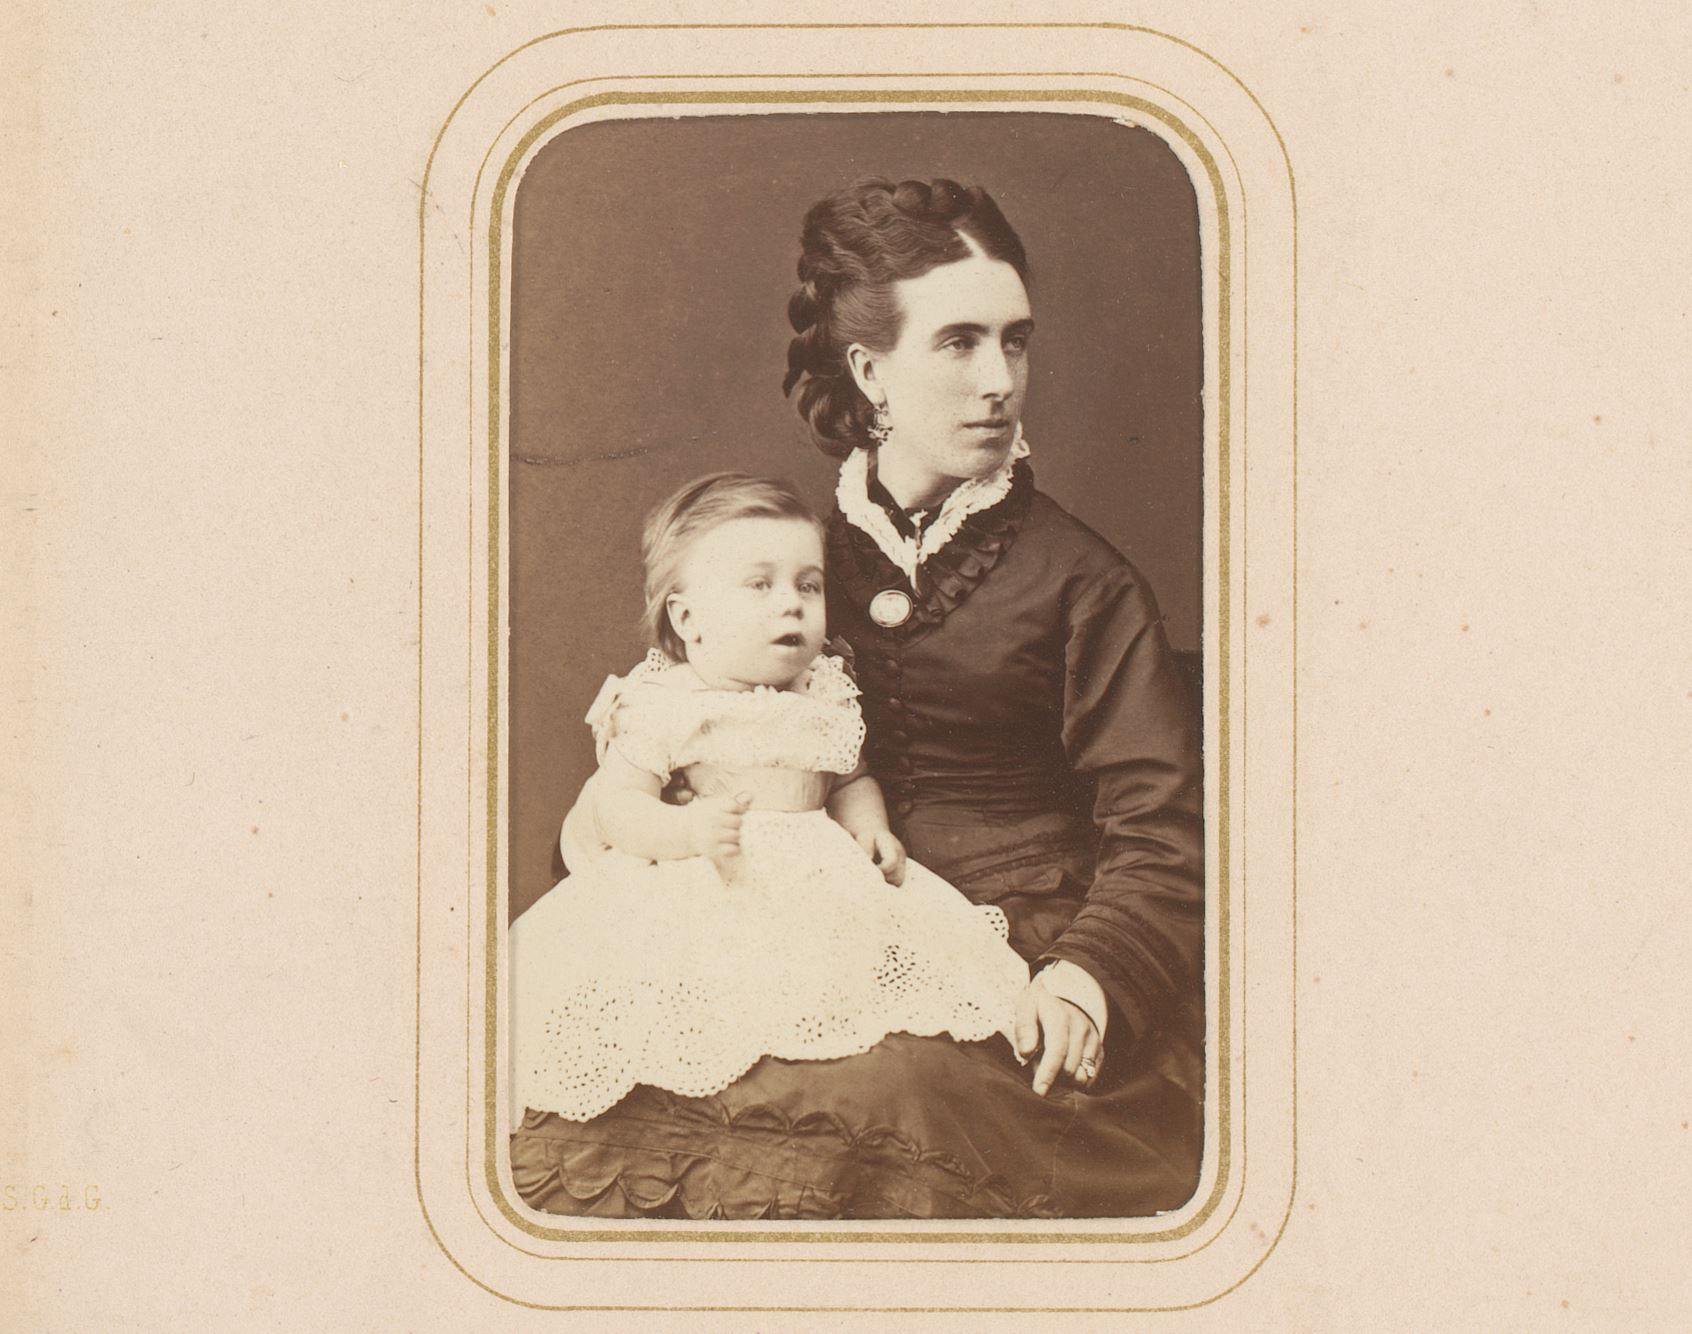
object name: photograph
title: Portret van een zittende vrouw met een baby in witte jurk op schoot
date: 1874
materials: cardboard, photographic support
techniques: albumen print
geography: london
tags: sitting figure - aa - female human figure, historical persons - bb - woman, infant, baby ~ the ages of man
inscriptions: date: ‘1874’, inscription: ‘G [+] R Lavis/ PHOTOGRAPHERS &/ MINIATURE PAINTERS/ 135, REGENT St/ W./ AND AT/ 42, Terminus Place,/ EASTBOURNE./ This picture can be enlarged to any size and/ a painting produced on paper or canvass.’